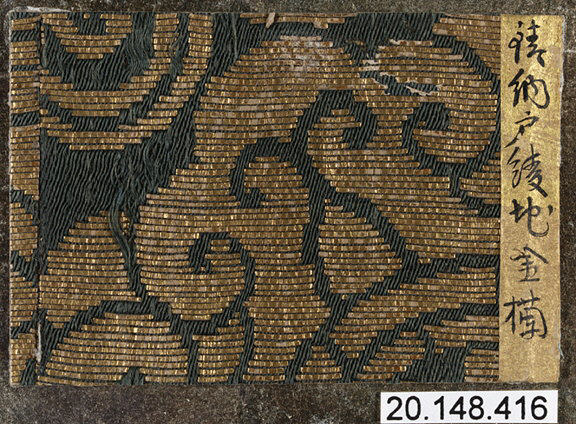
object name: piece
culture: japanese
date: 1701-1800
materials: silk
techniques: compound weave